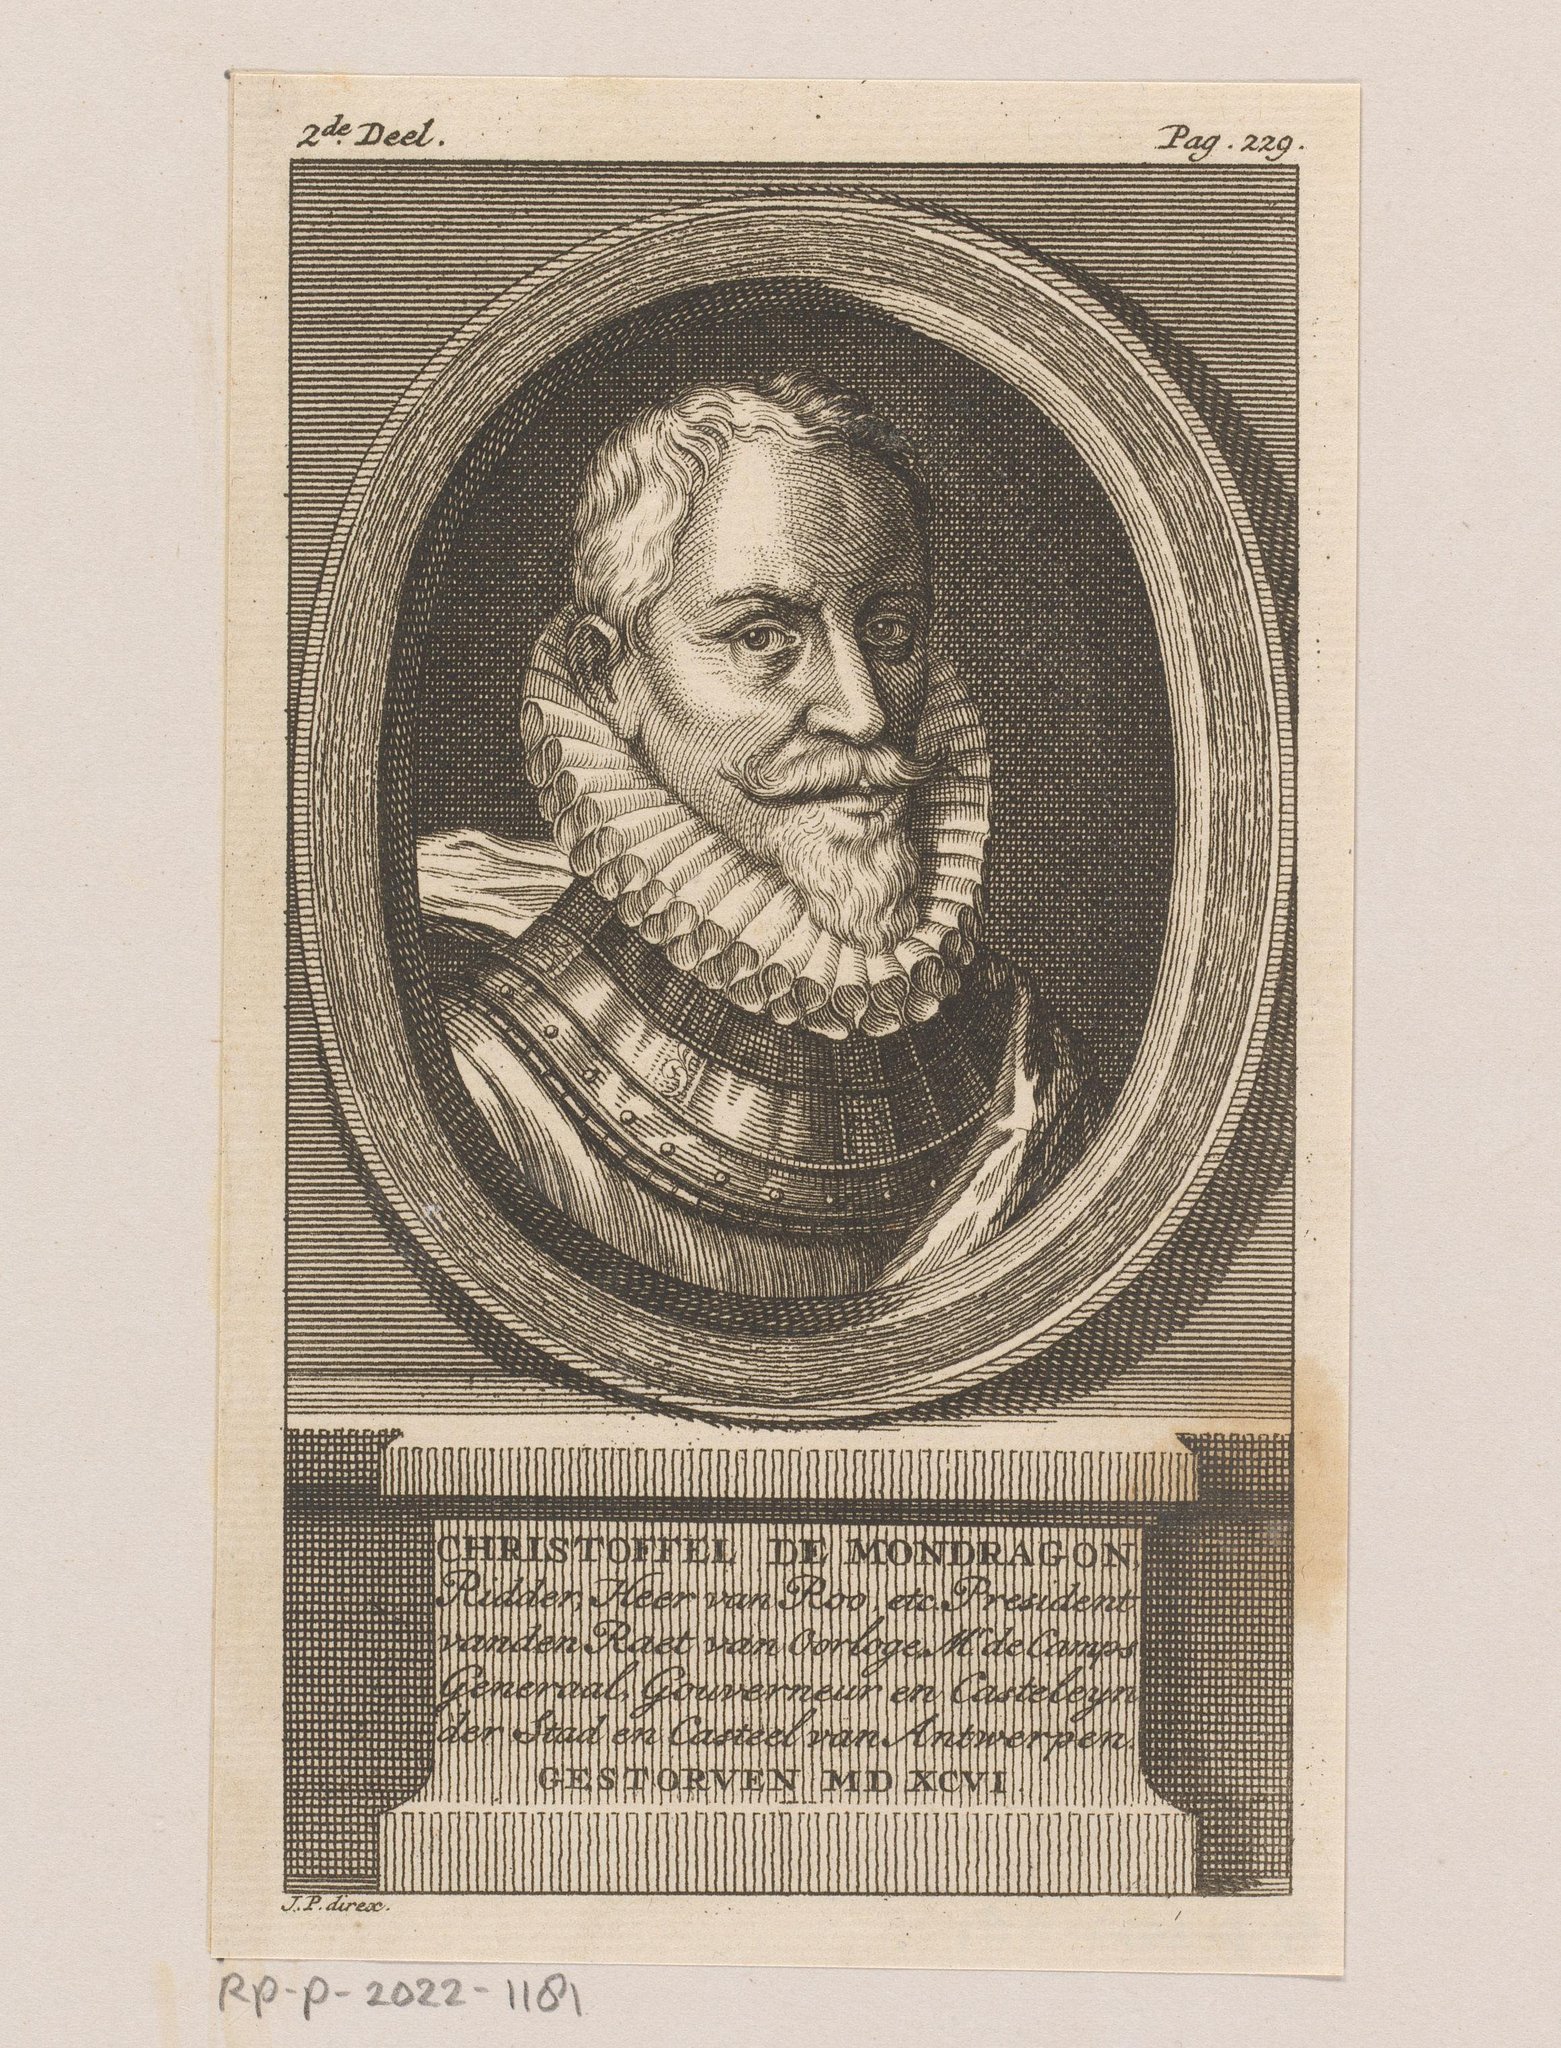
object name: print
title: Christoffel de Mondragon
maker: jan punt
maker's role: draughtsman, print maker, publisher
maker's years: 1711-1779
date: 1786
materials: paper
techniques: engraving, etching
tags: armour, historical persons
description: Prent waarschijnlijk uit: Meteren, Emanuel van. Oorlogen en geschiedenissen der Nederlanderen en derzelver nabuuren. Amsterdam: Steven Jacobus Baalde, 1786, dl. 2, p. 229.